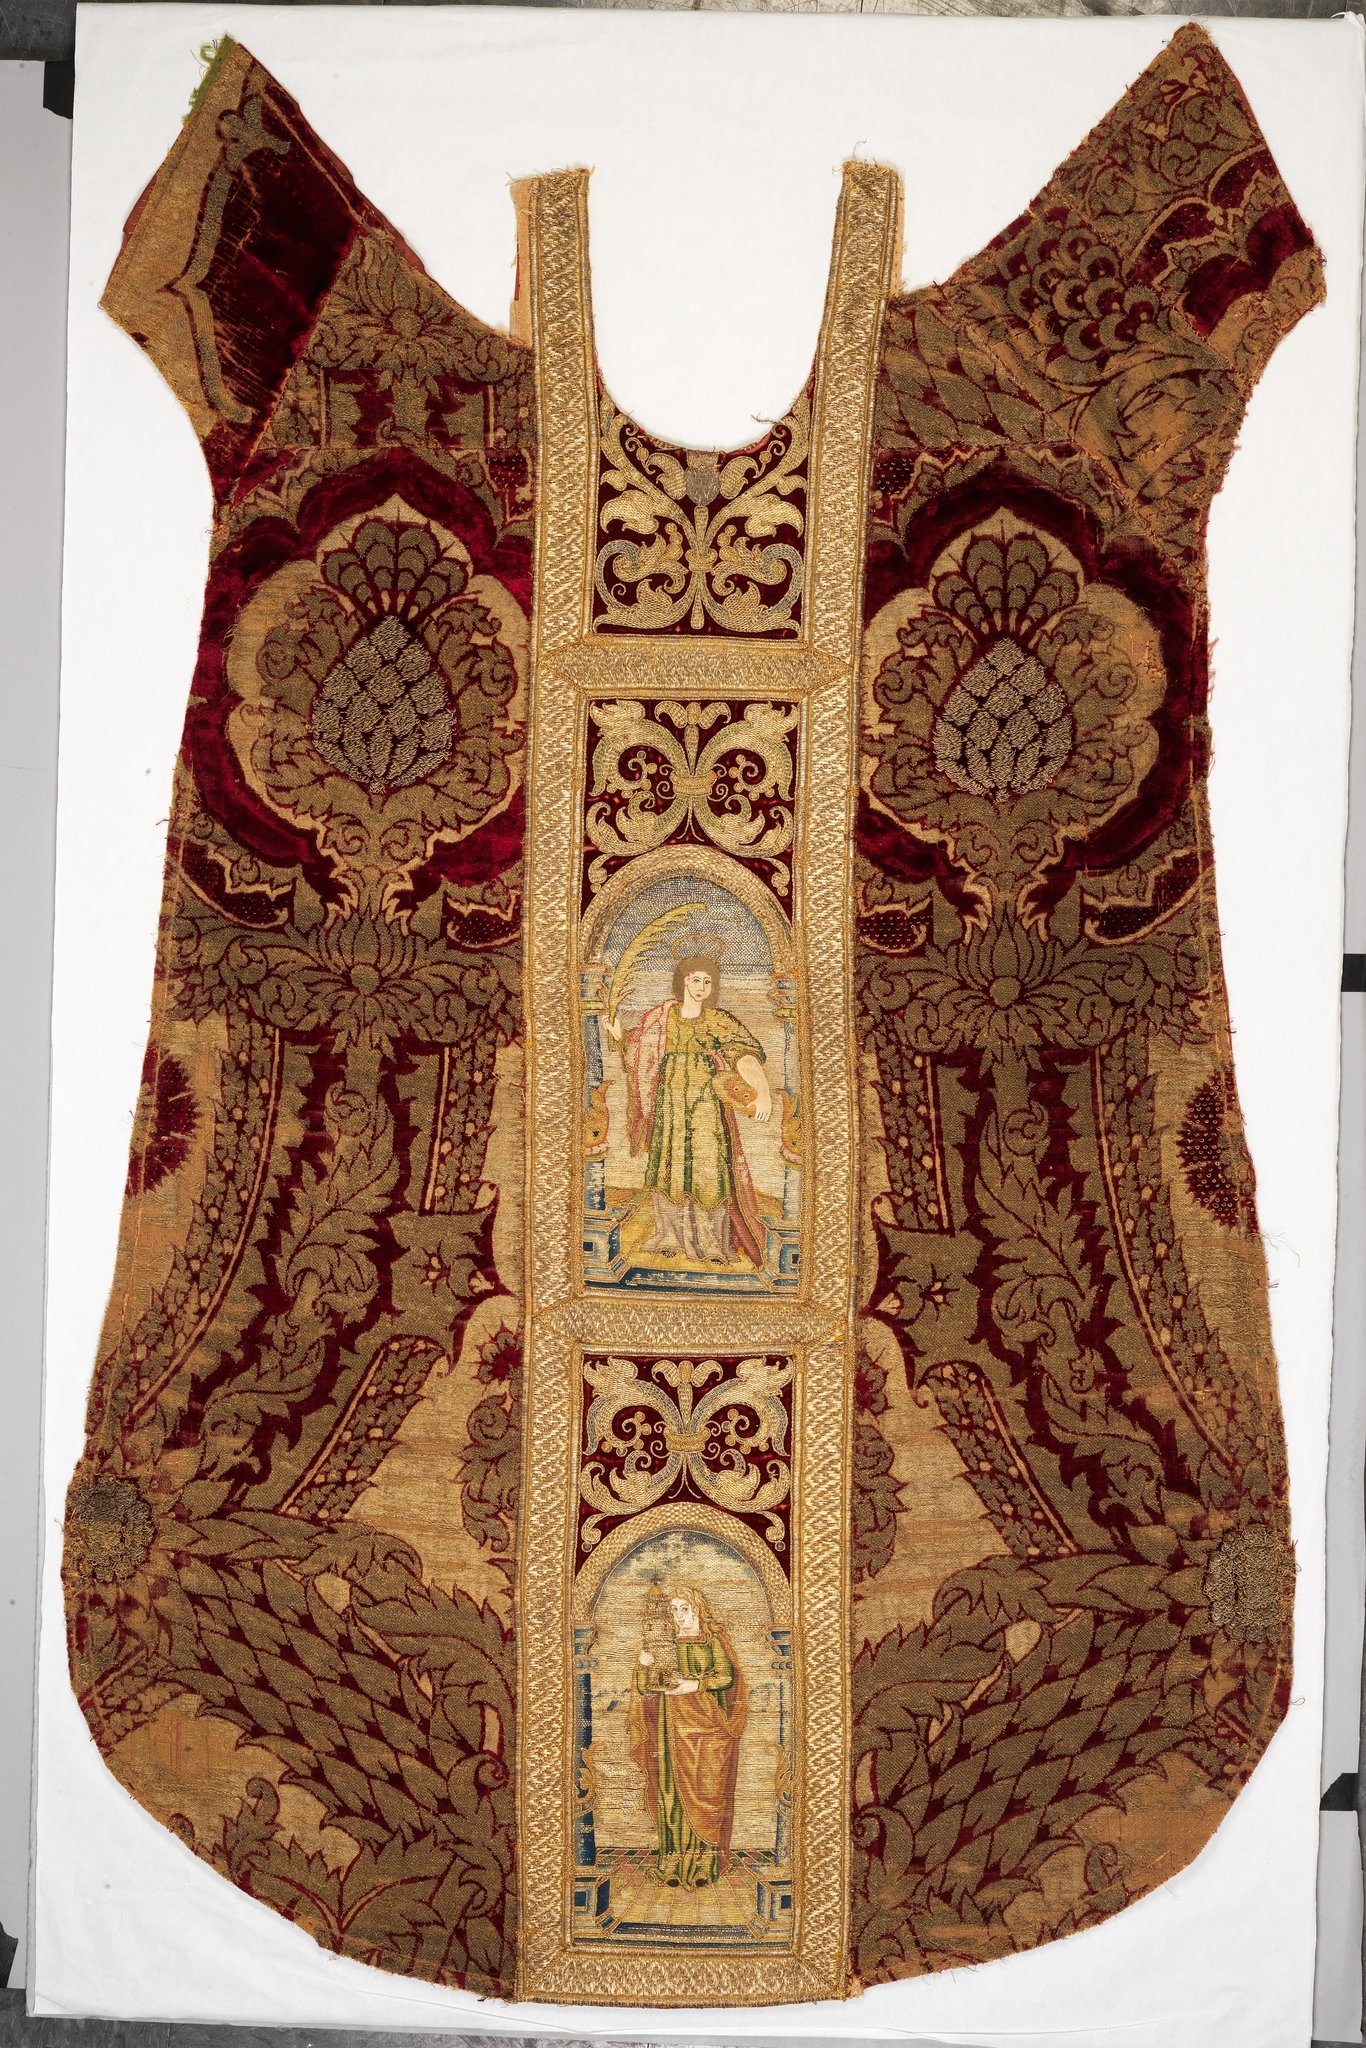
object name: orphrey fragment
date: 1501-1600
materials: metal thread, silk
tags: women